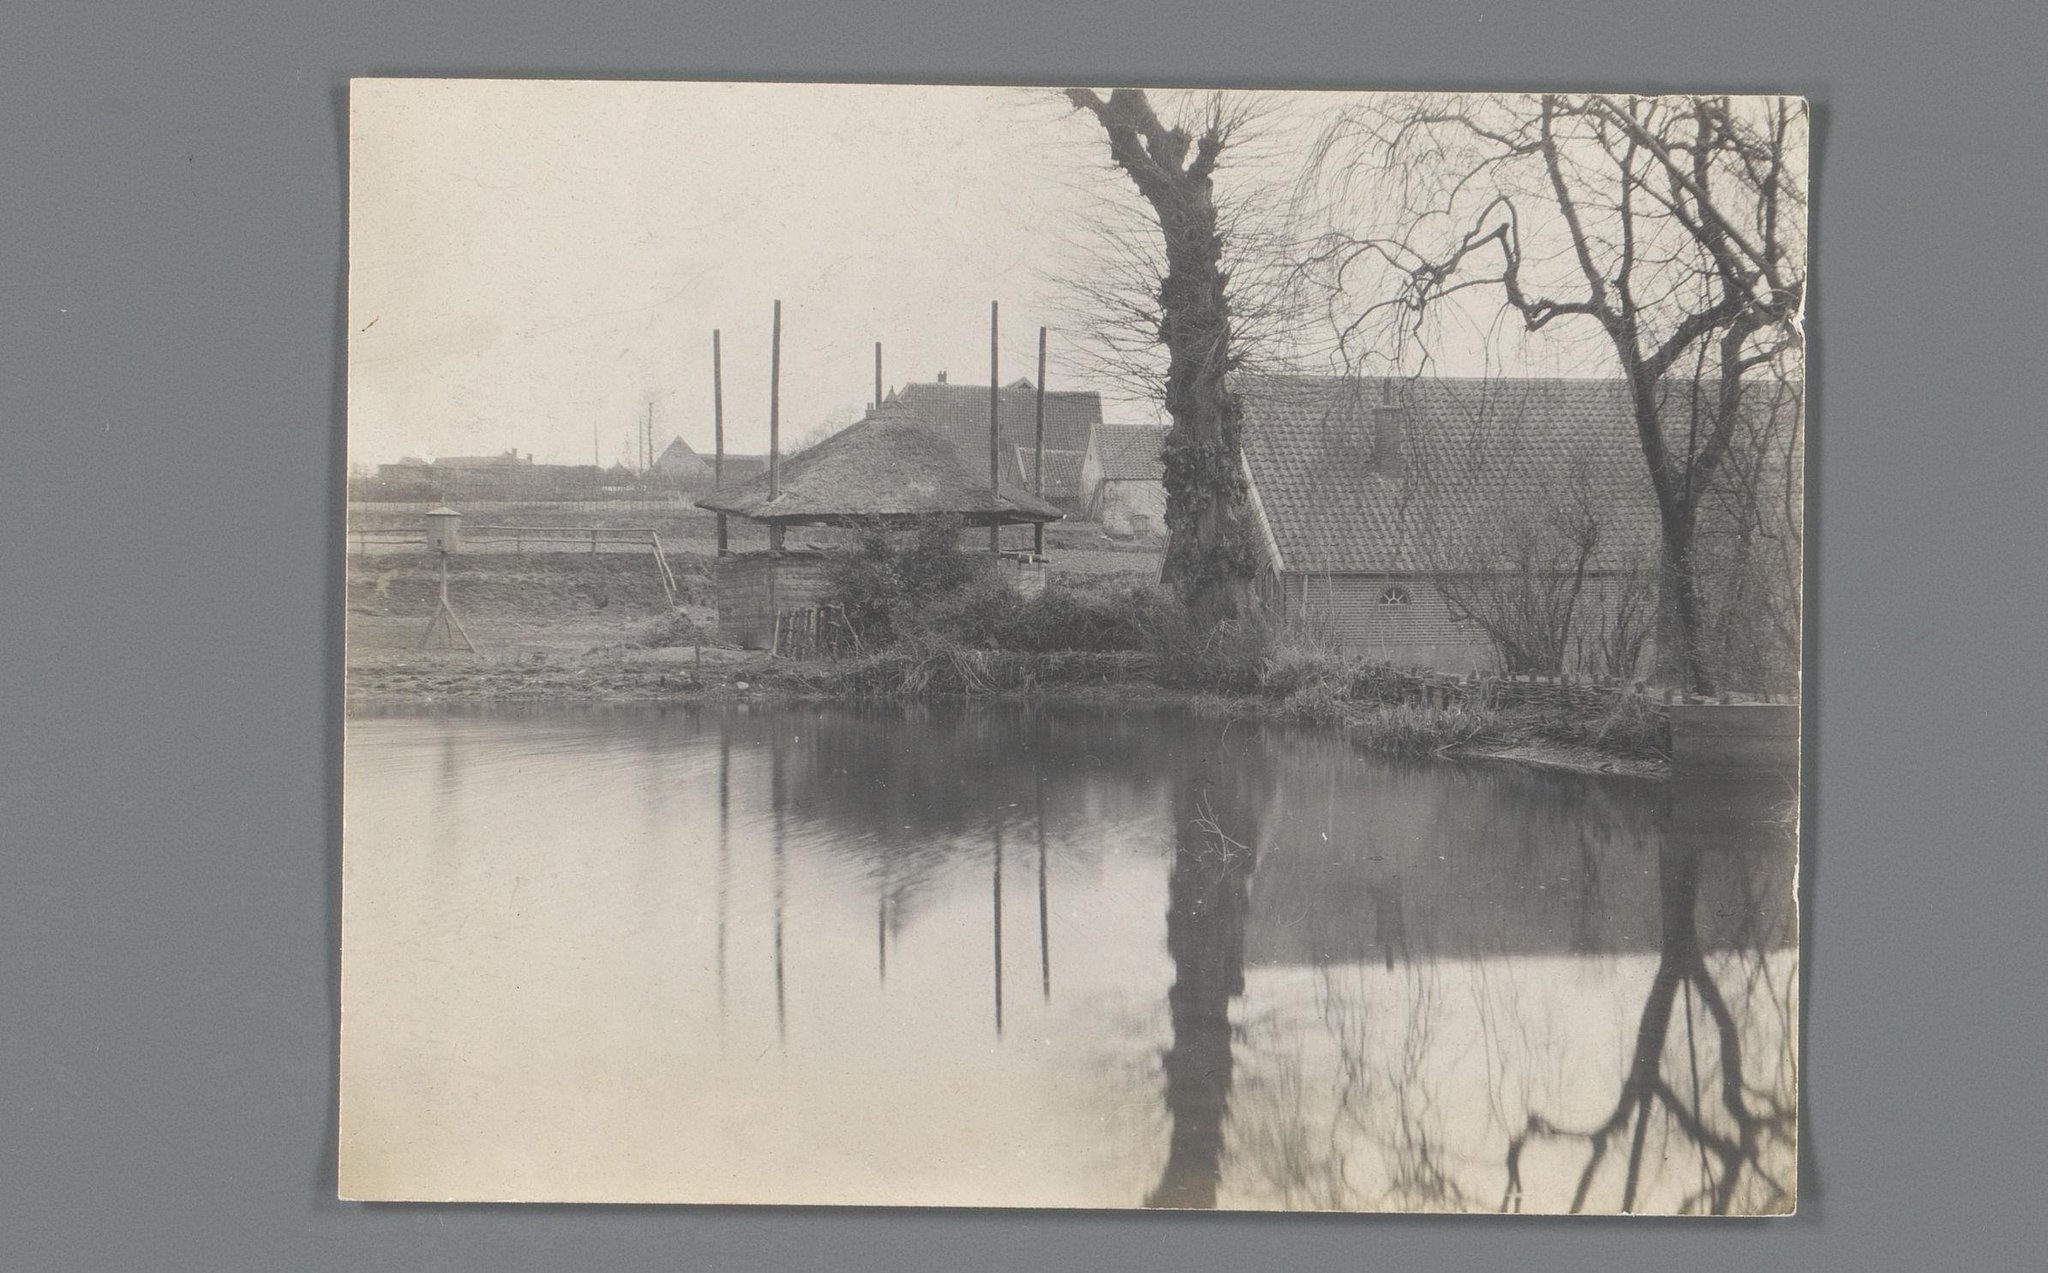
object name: photograph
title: Boerderij met hooischuur aan het water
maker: willem de jong (fotograaf)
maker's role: arts, fotograaf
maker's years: 1864-1918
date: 1895-1918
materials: paper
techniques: gelatin silver print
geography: netherlands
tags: pond, pool, hay-stack, farm (building)